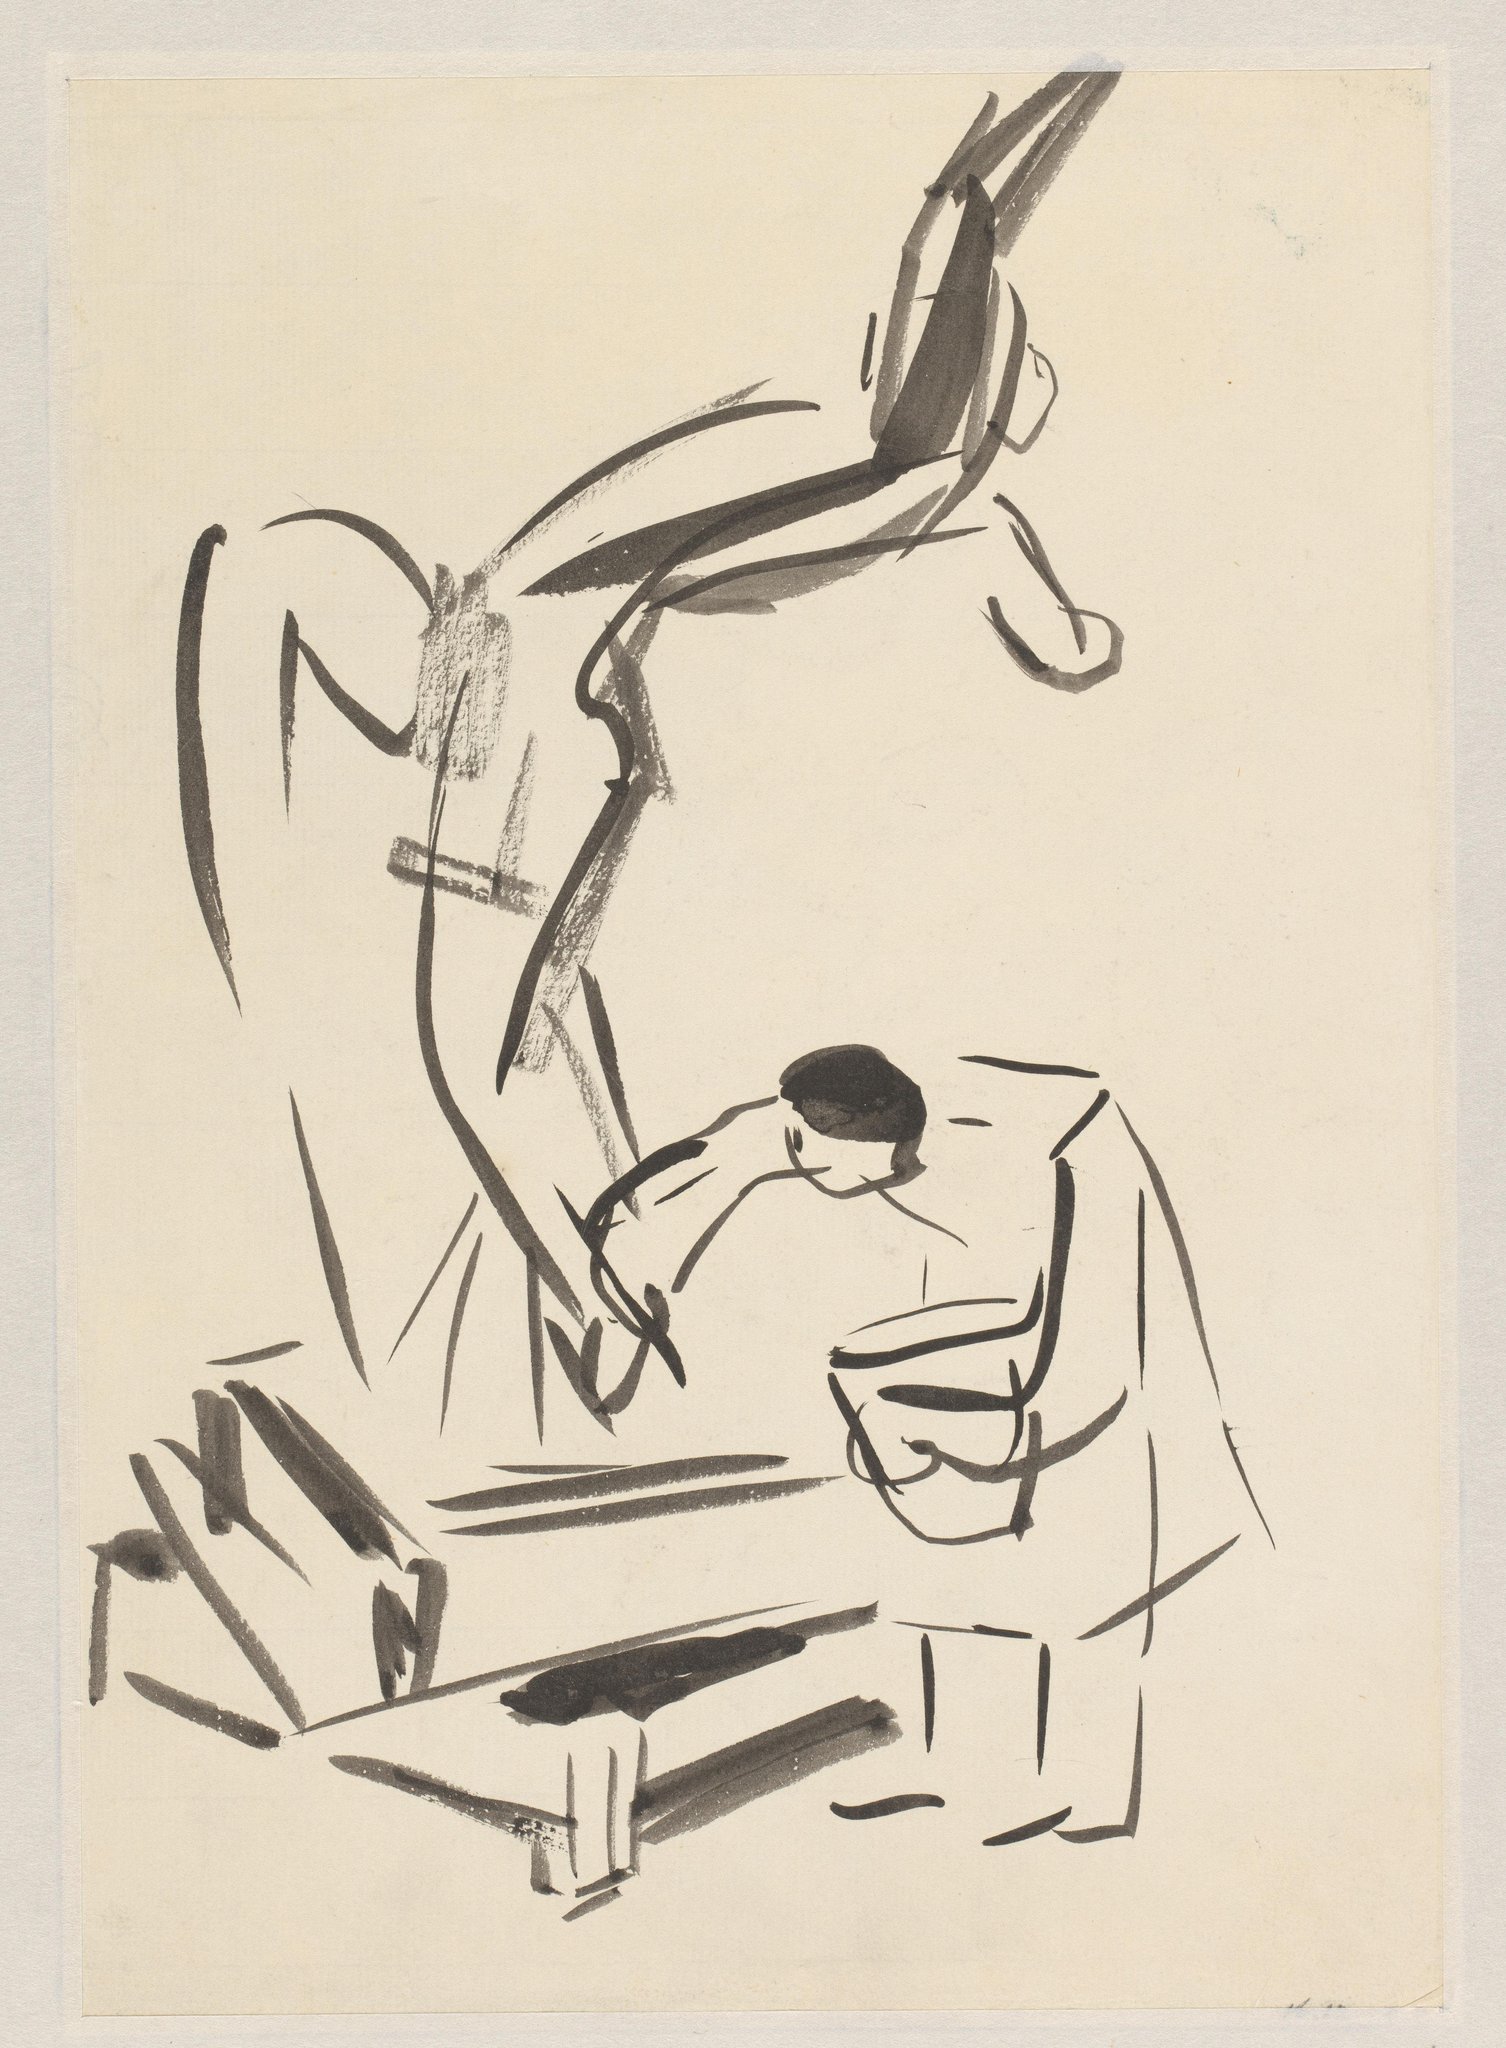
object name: drawing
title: Schets van een schilder of beeldhouwer, aan het werk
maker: rik wouters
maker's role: draughtsman, print maker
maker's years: 1882-1916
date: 1892-1916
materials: paper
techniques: brush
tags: sculptor at work, painter at work, in his studio